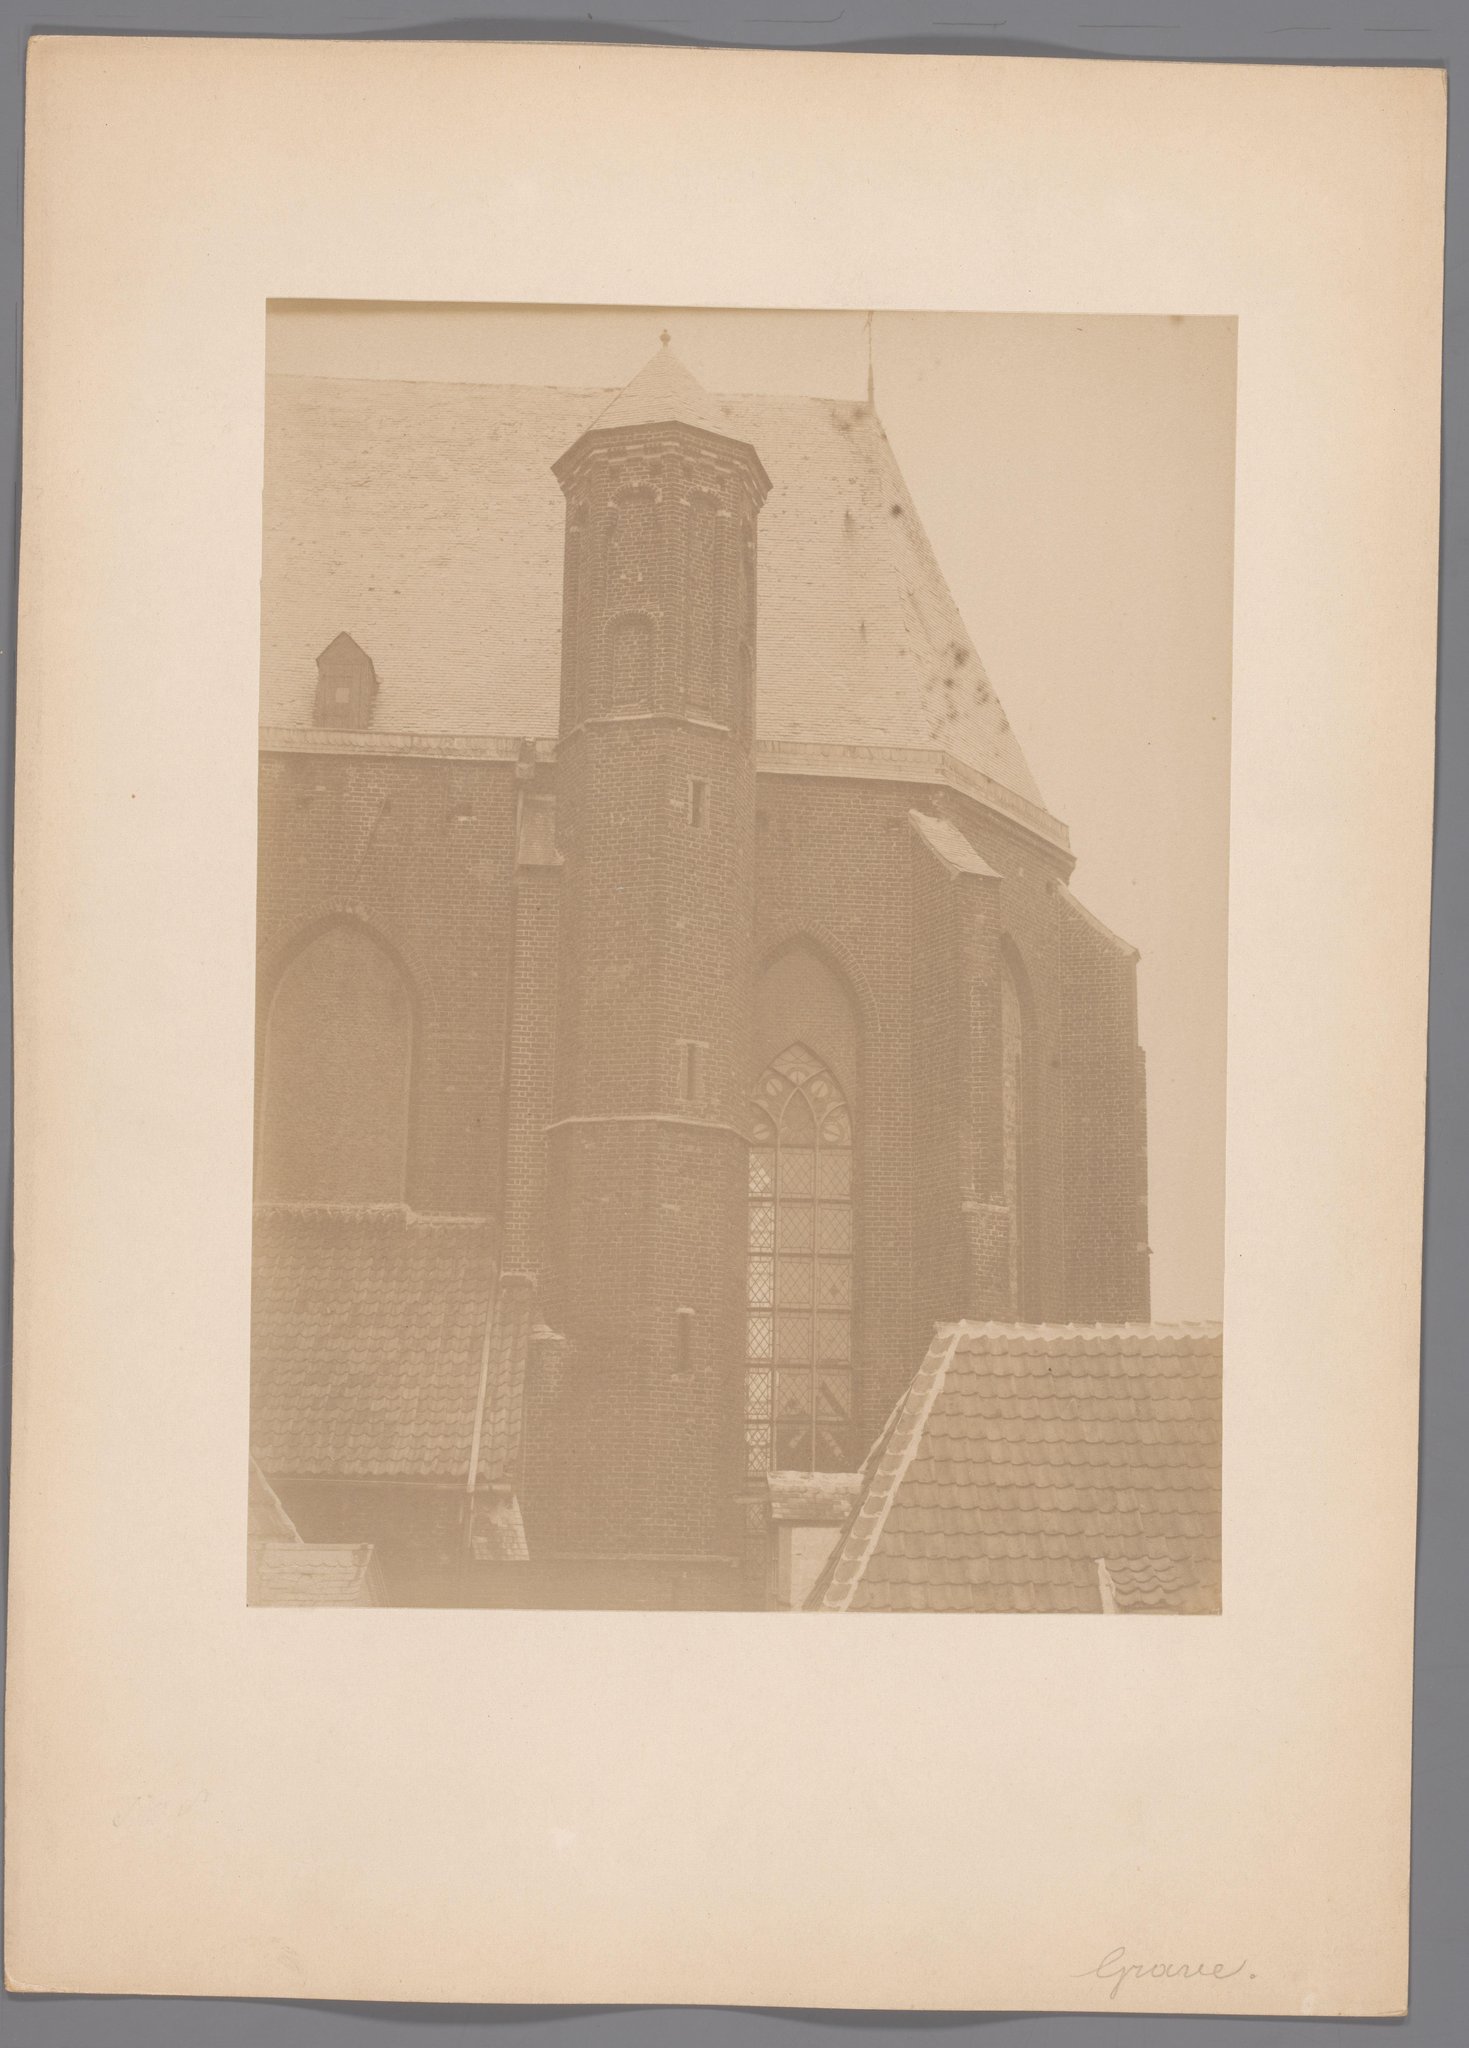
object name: photograph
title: Gedeelte van de Sint-Elisabethkerk te Grave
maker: anoniem (monumentenzorg)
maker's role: fotograaf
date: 1890-1920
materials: cardboard, photographic support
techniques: albumen print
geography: grave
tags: parts of church exterior and annexes: choir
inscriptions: annotation: ‘Grave/ R.C. kerk (koor)’, annotation: ‘Grave’